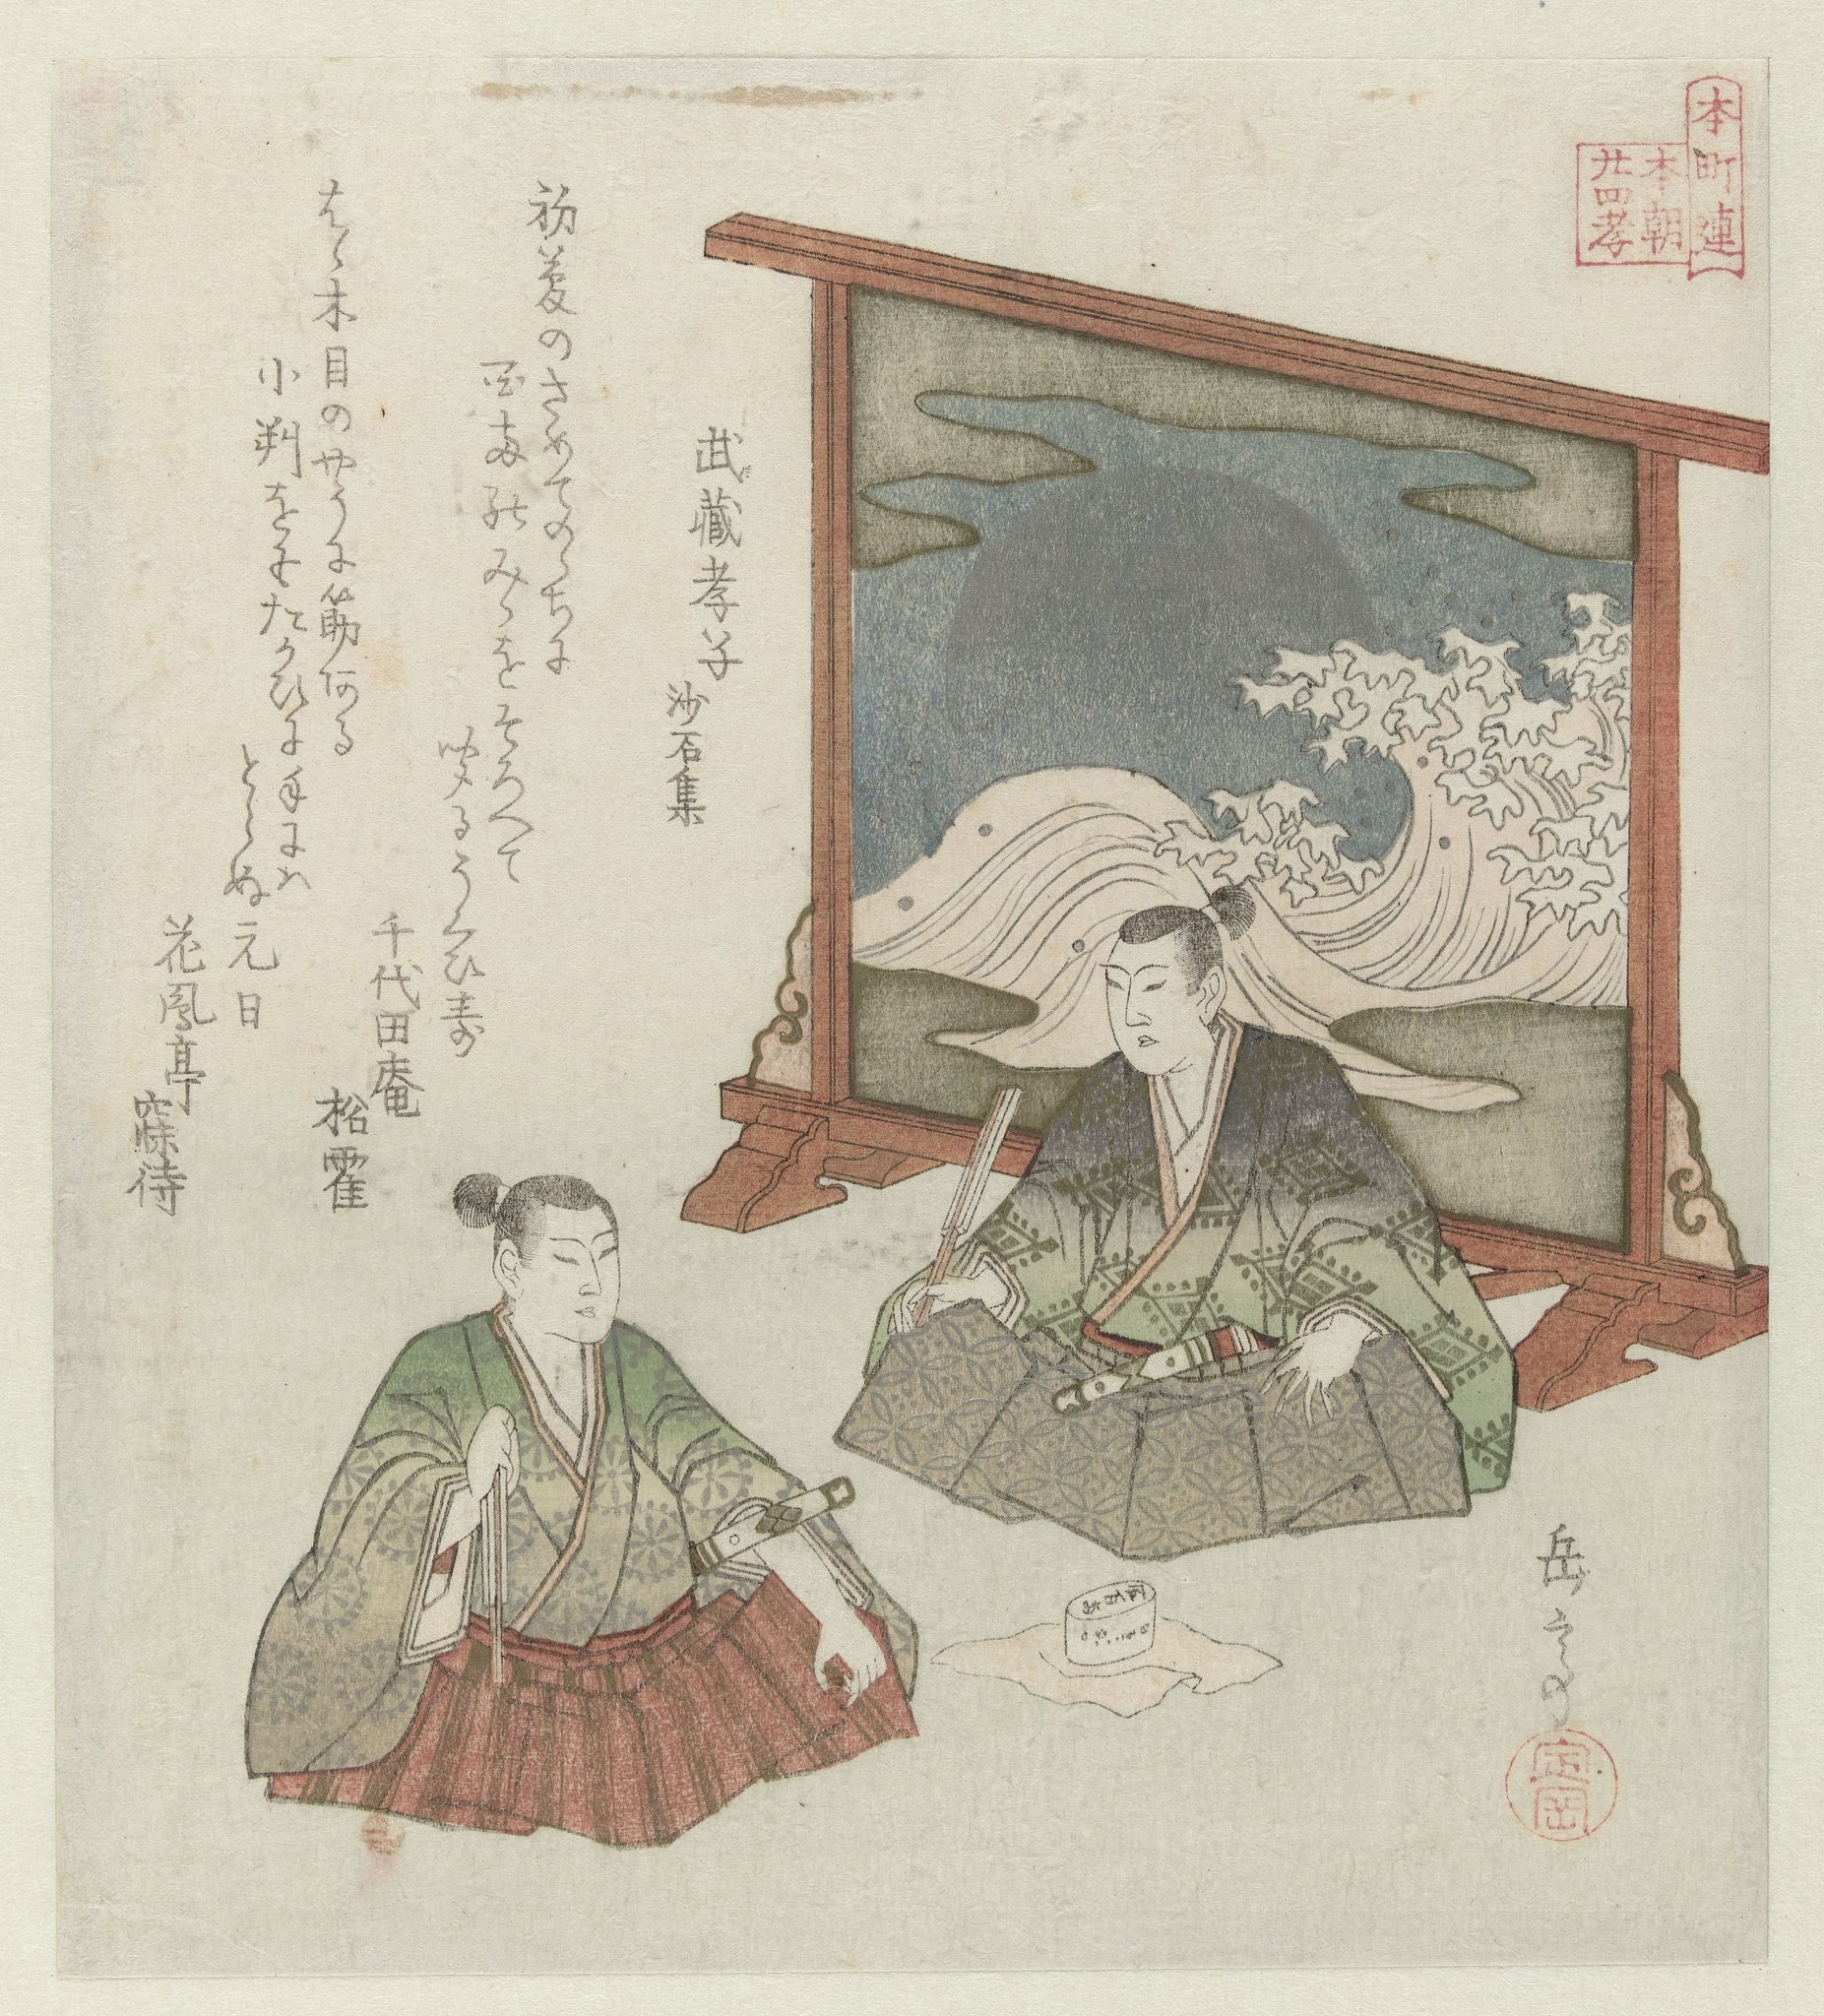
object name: surimono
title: Twenty-four Japanese examples of filial piety for the Honchôren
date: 1821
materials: paper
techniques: woodcut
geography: japan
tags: screen, folding screen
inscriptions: collector's mark, verso, stamped: Lugt 2228, collector's mark, passe-partout, bottom left, printed: JABdH with a rooster.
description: Twee jongens voor een scherm waarop een branding en de maan, tussen hen in een goudstuk. De jongens hebben allebei recent hun vaders verloren, één is arm en de ander rijk. De arme jongen heeft zijn vader in een droom gezien die hem vertelde om de schuld bij de zoon van de rijke man af te lossen. Hier probeert hij dat te doen door een goudstuk aan te bieden. De rijke jongen weigert het goudstuk en vraagt hem om in plaats van betaling een offer aan hun beide vaders te brengen. Met twee gedichten, een gedicht gaat over de droom: Wakker worden van de eerste voorspoedige droom is als honderd goudstukken wanneer het oor ook de zang van de spotvogel hoort.